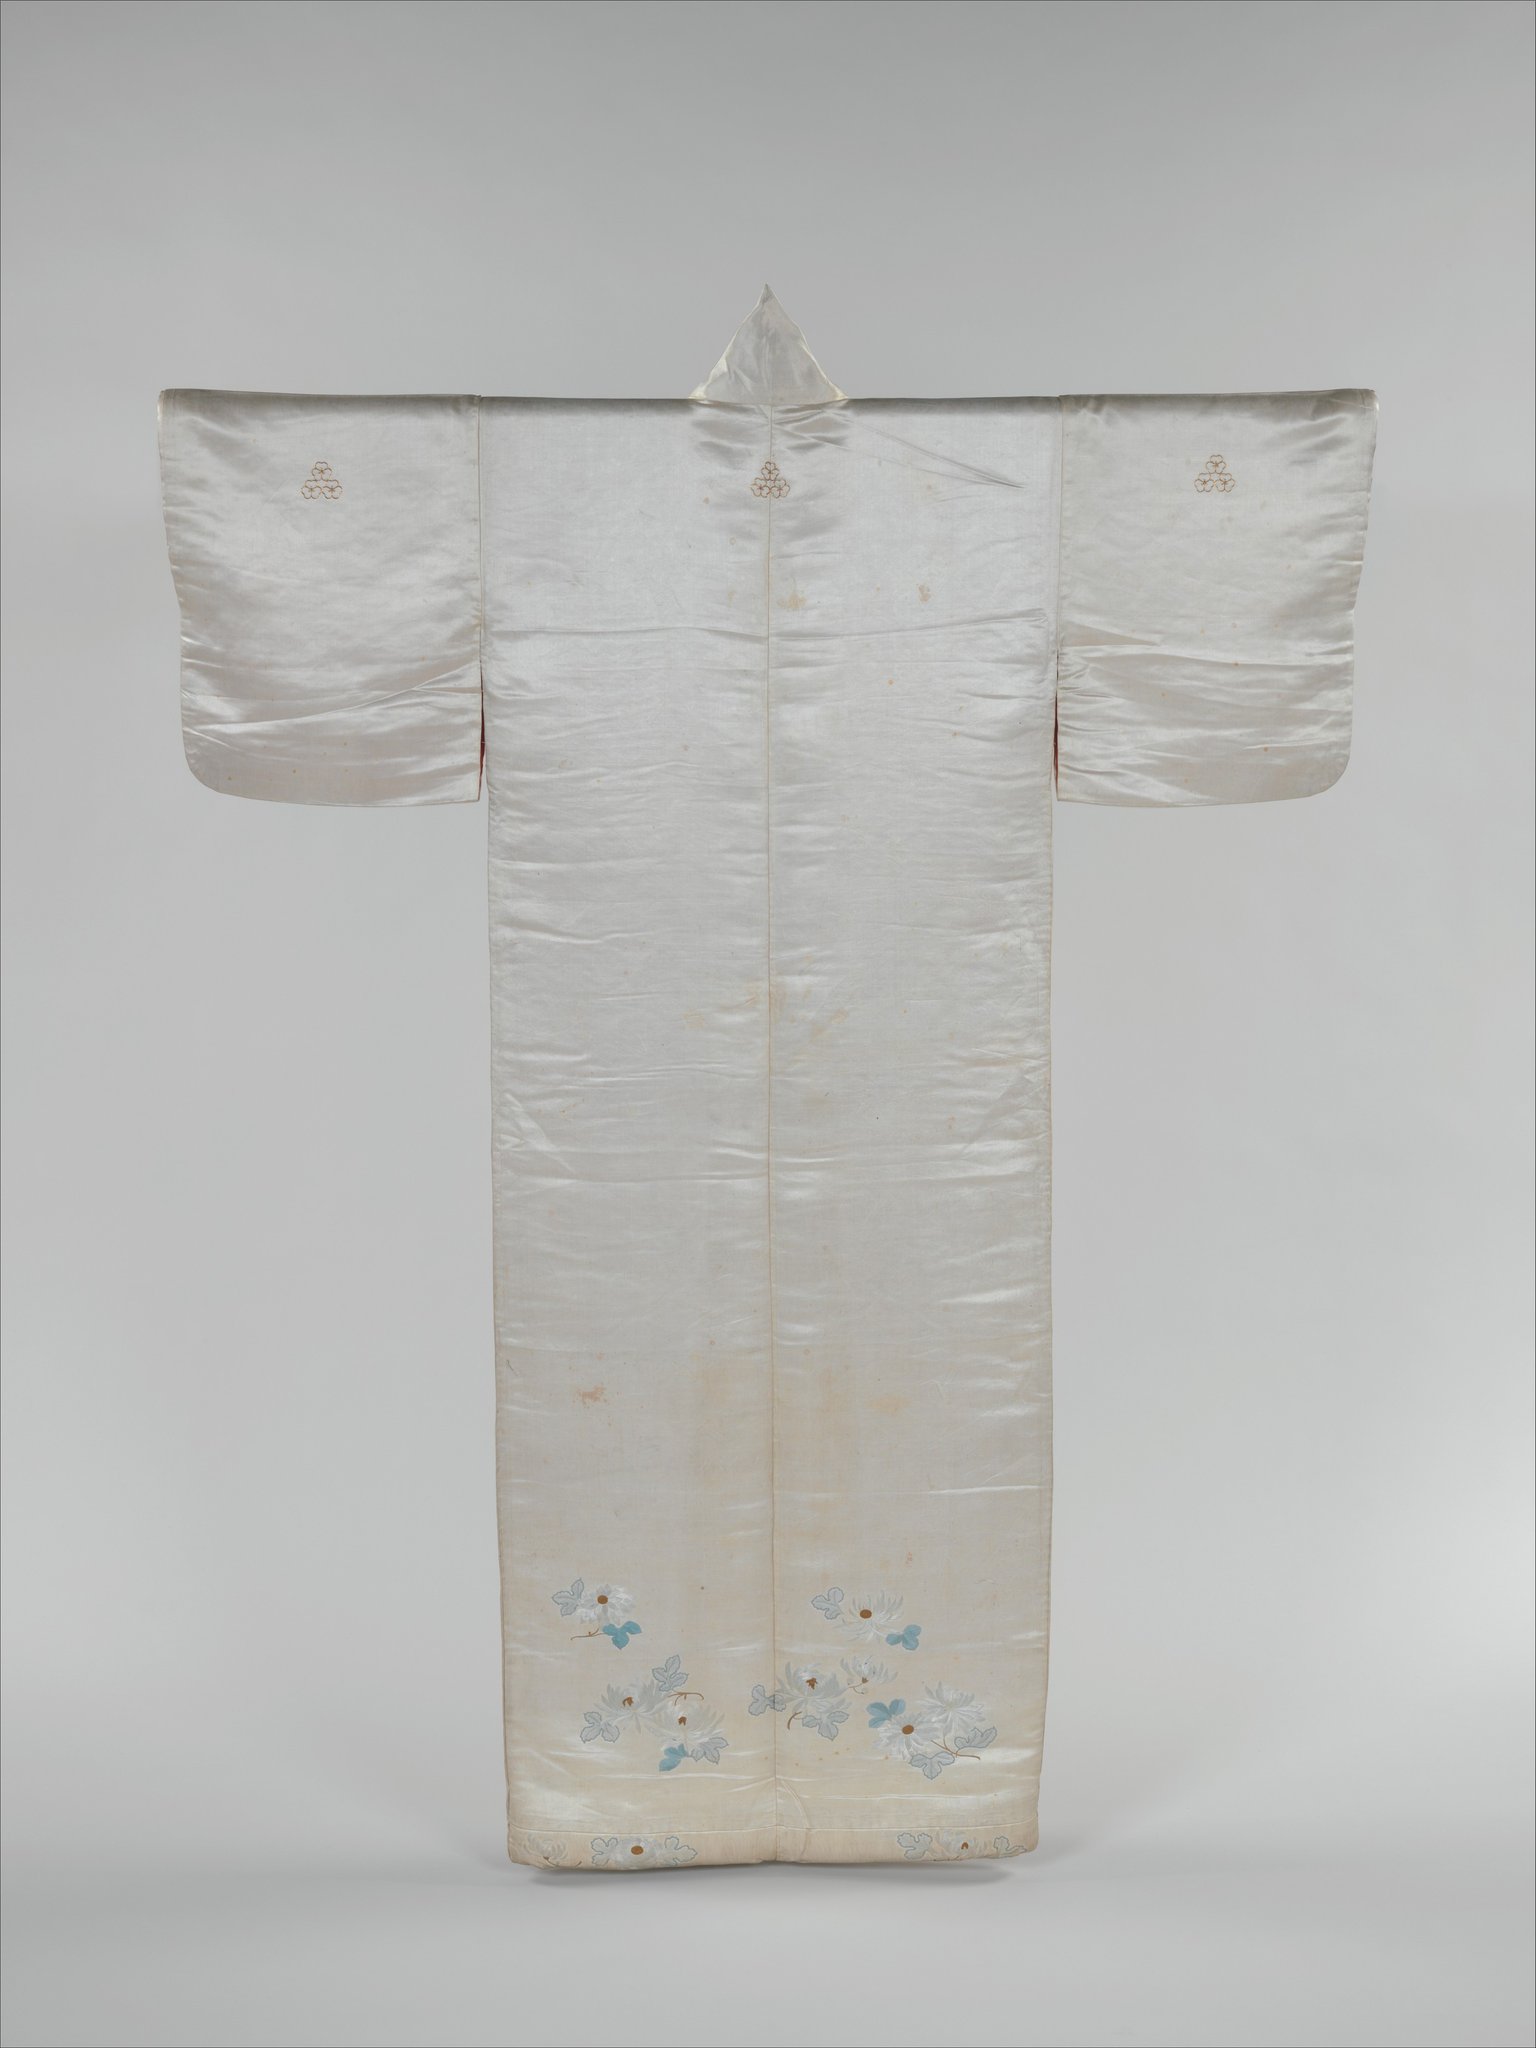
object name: kosode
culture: japanese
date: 1868-1912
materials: metal thread, silk